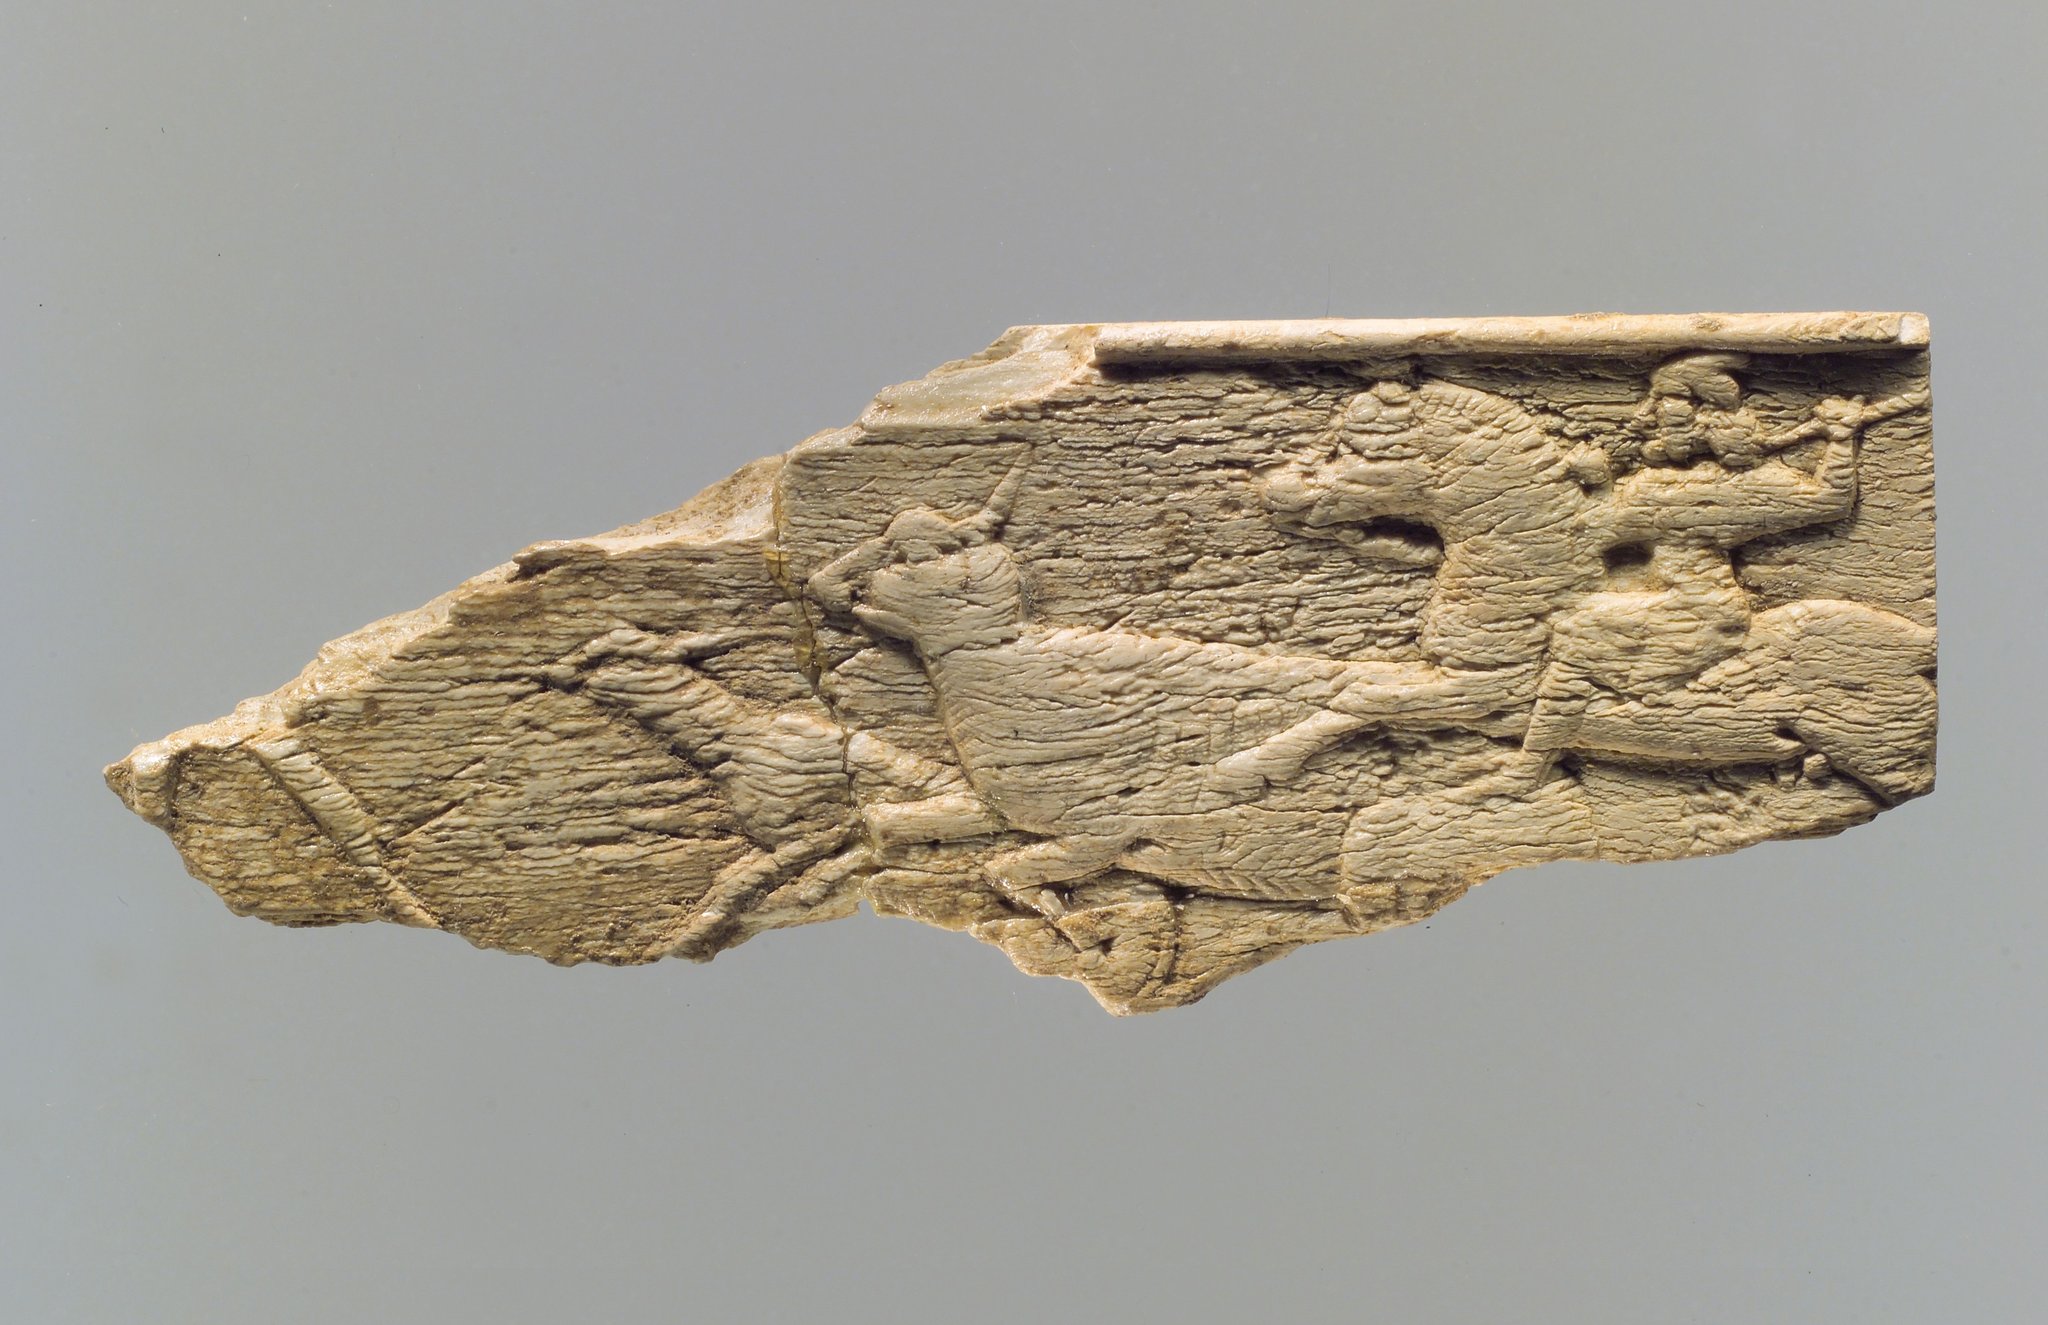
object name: relief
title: Panel fragment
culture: iranian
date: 800-601 BCE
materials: ivory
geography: iran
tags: horses